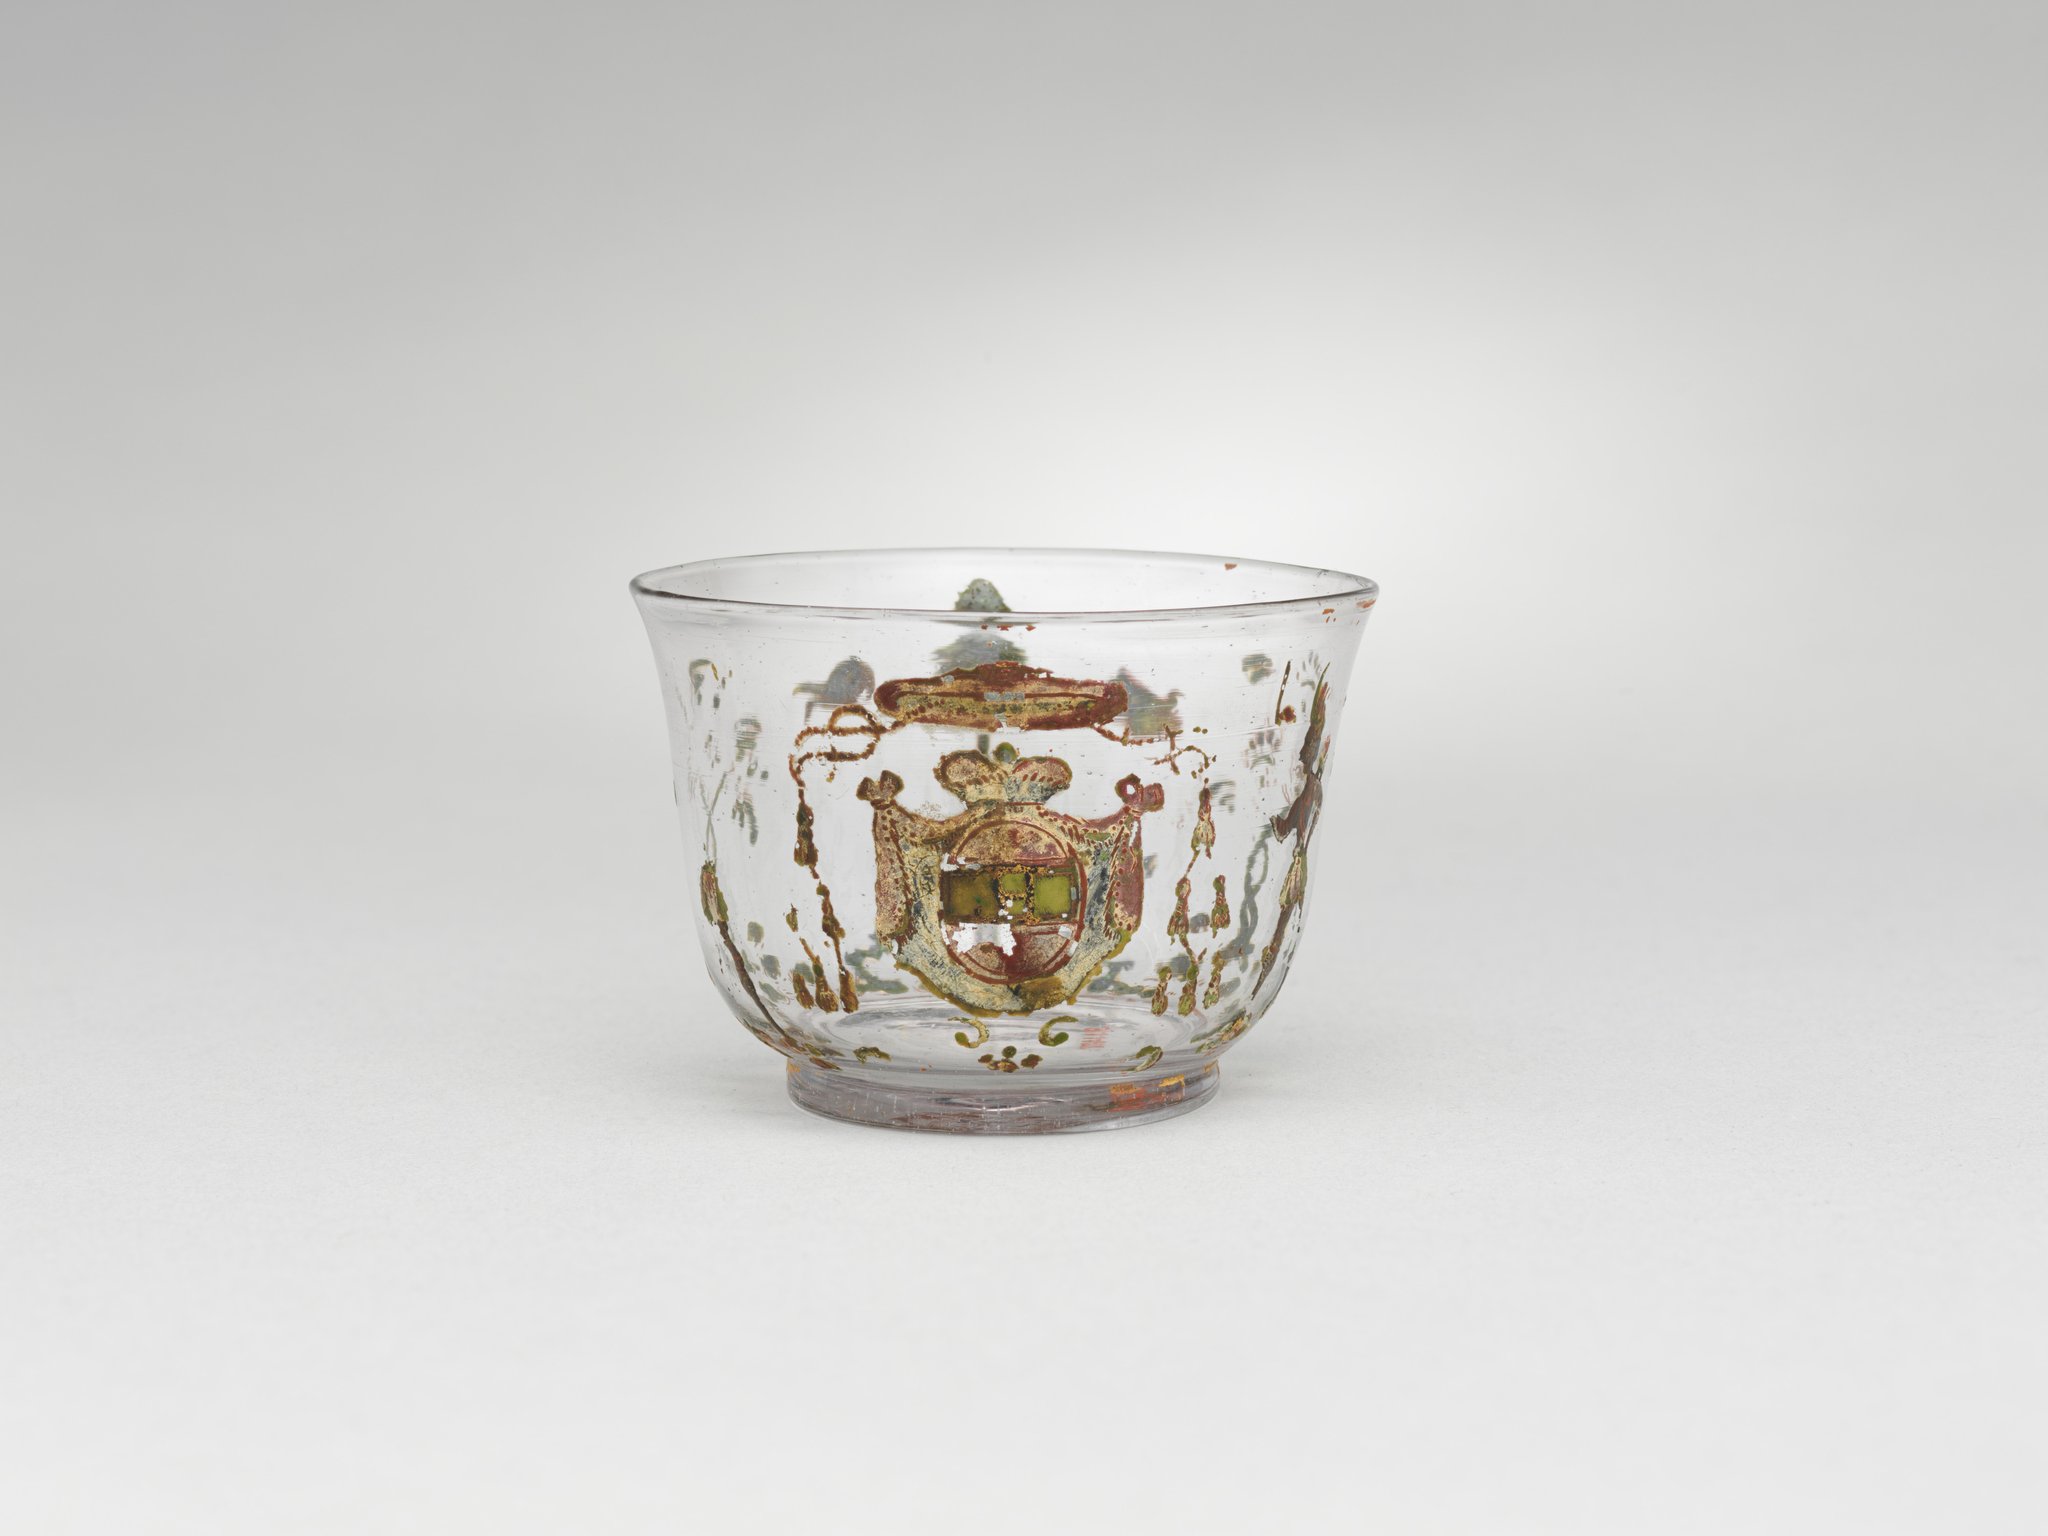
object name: cup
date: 1701-1800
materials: glass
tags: coat of arms